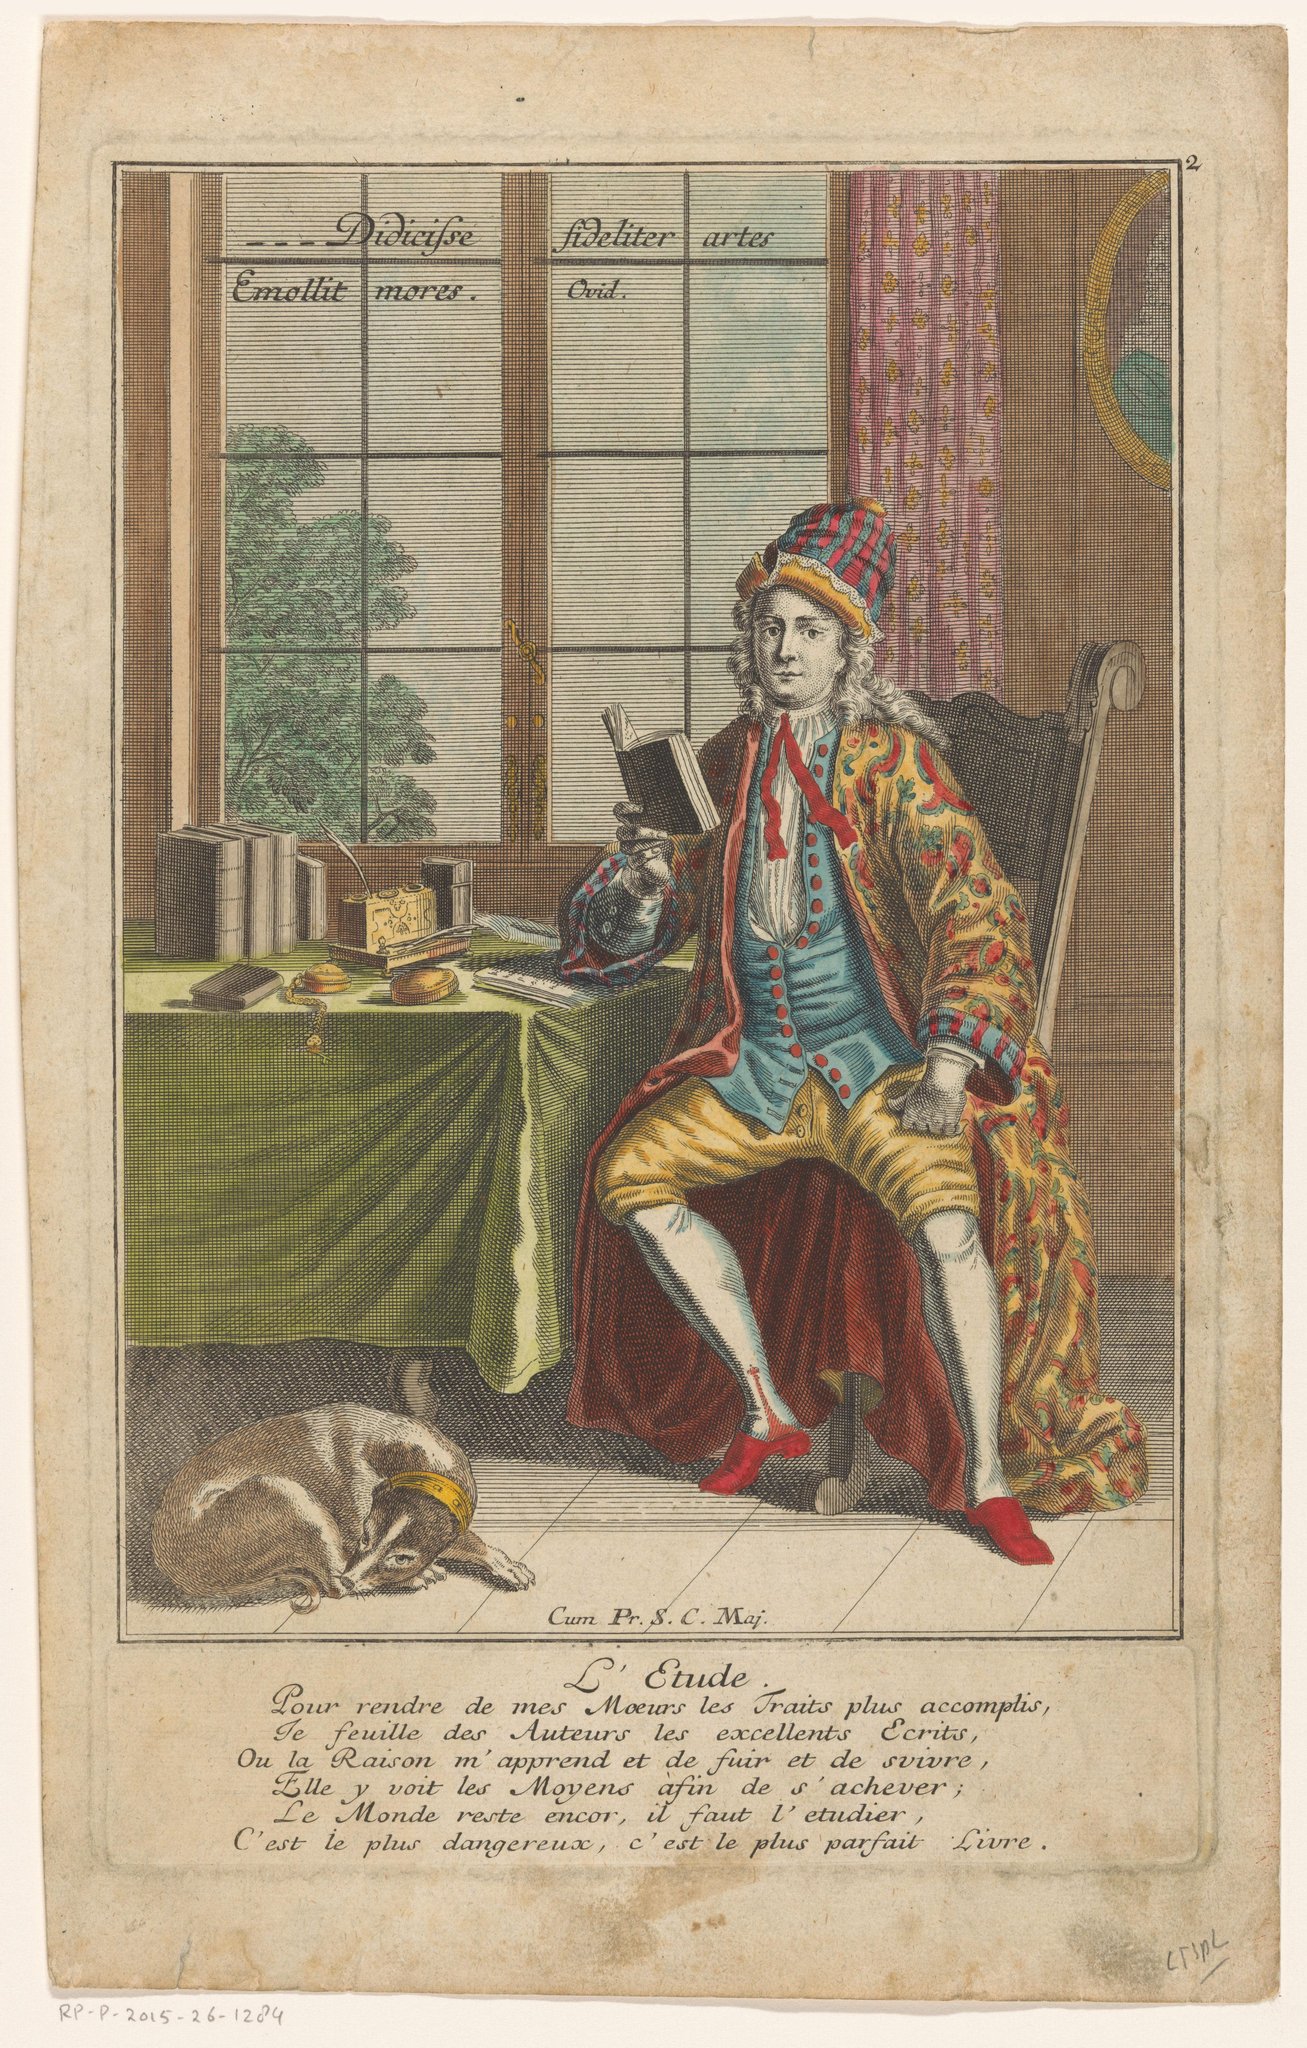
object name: print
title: Man met een boek in zijn hand aan een schrijftafel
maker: Anonymous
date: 1700-1799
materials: paper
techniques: etching, hand coloring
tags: writing-table, writing-desk, ink-well, book, watch, dog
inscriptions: collector's mark: Lugt 4779, collector's mark: Lugt 2228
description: Een man zit met een boek in de hand aan een schrijftafel, gekleed in een kamerjas en met een muts op zijn hoofd. Op tafel liggen en staan verschillende objecten, waaronder een horloge, boeken en een inktstel. Op de grond voor de tafel ligt een hond. Onder een zesregelig vers in het Frans; boven voor het raam een citaat van Ovidius.